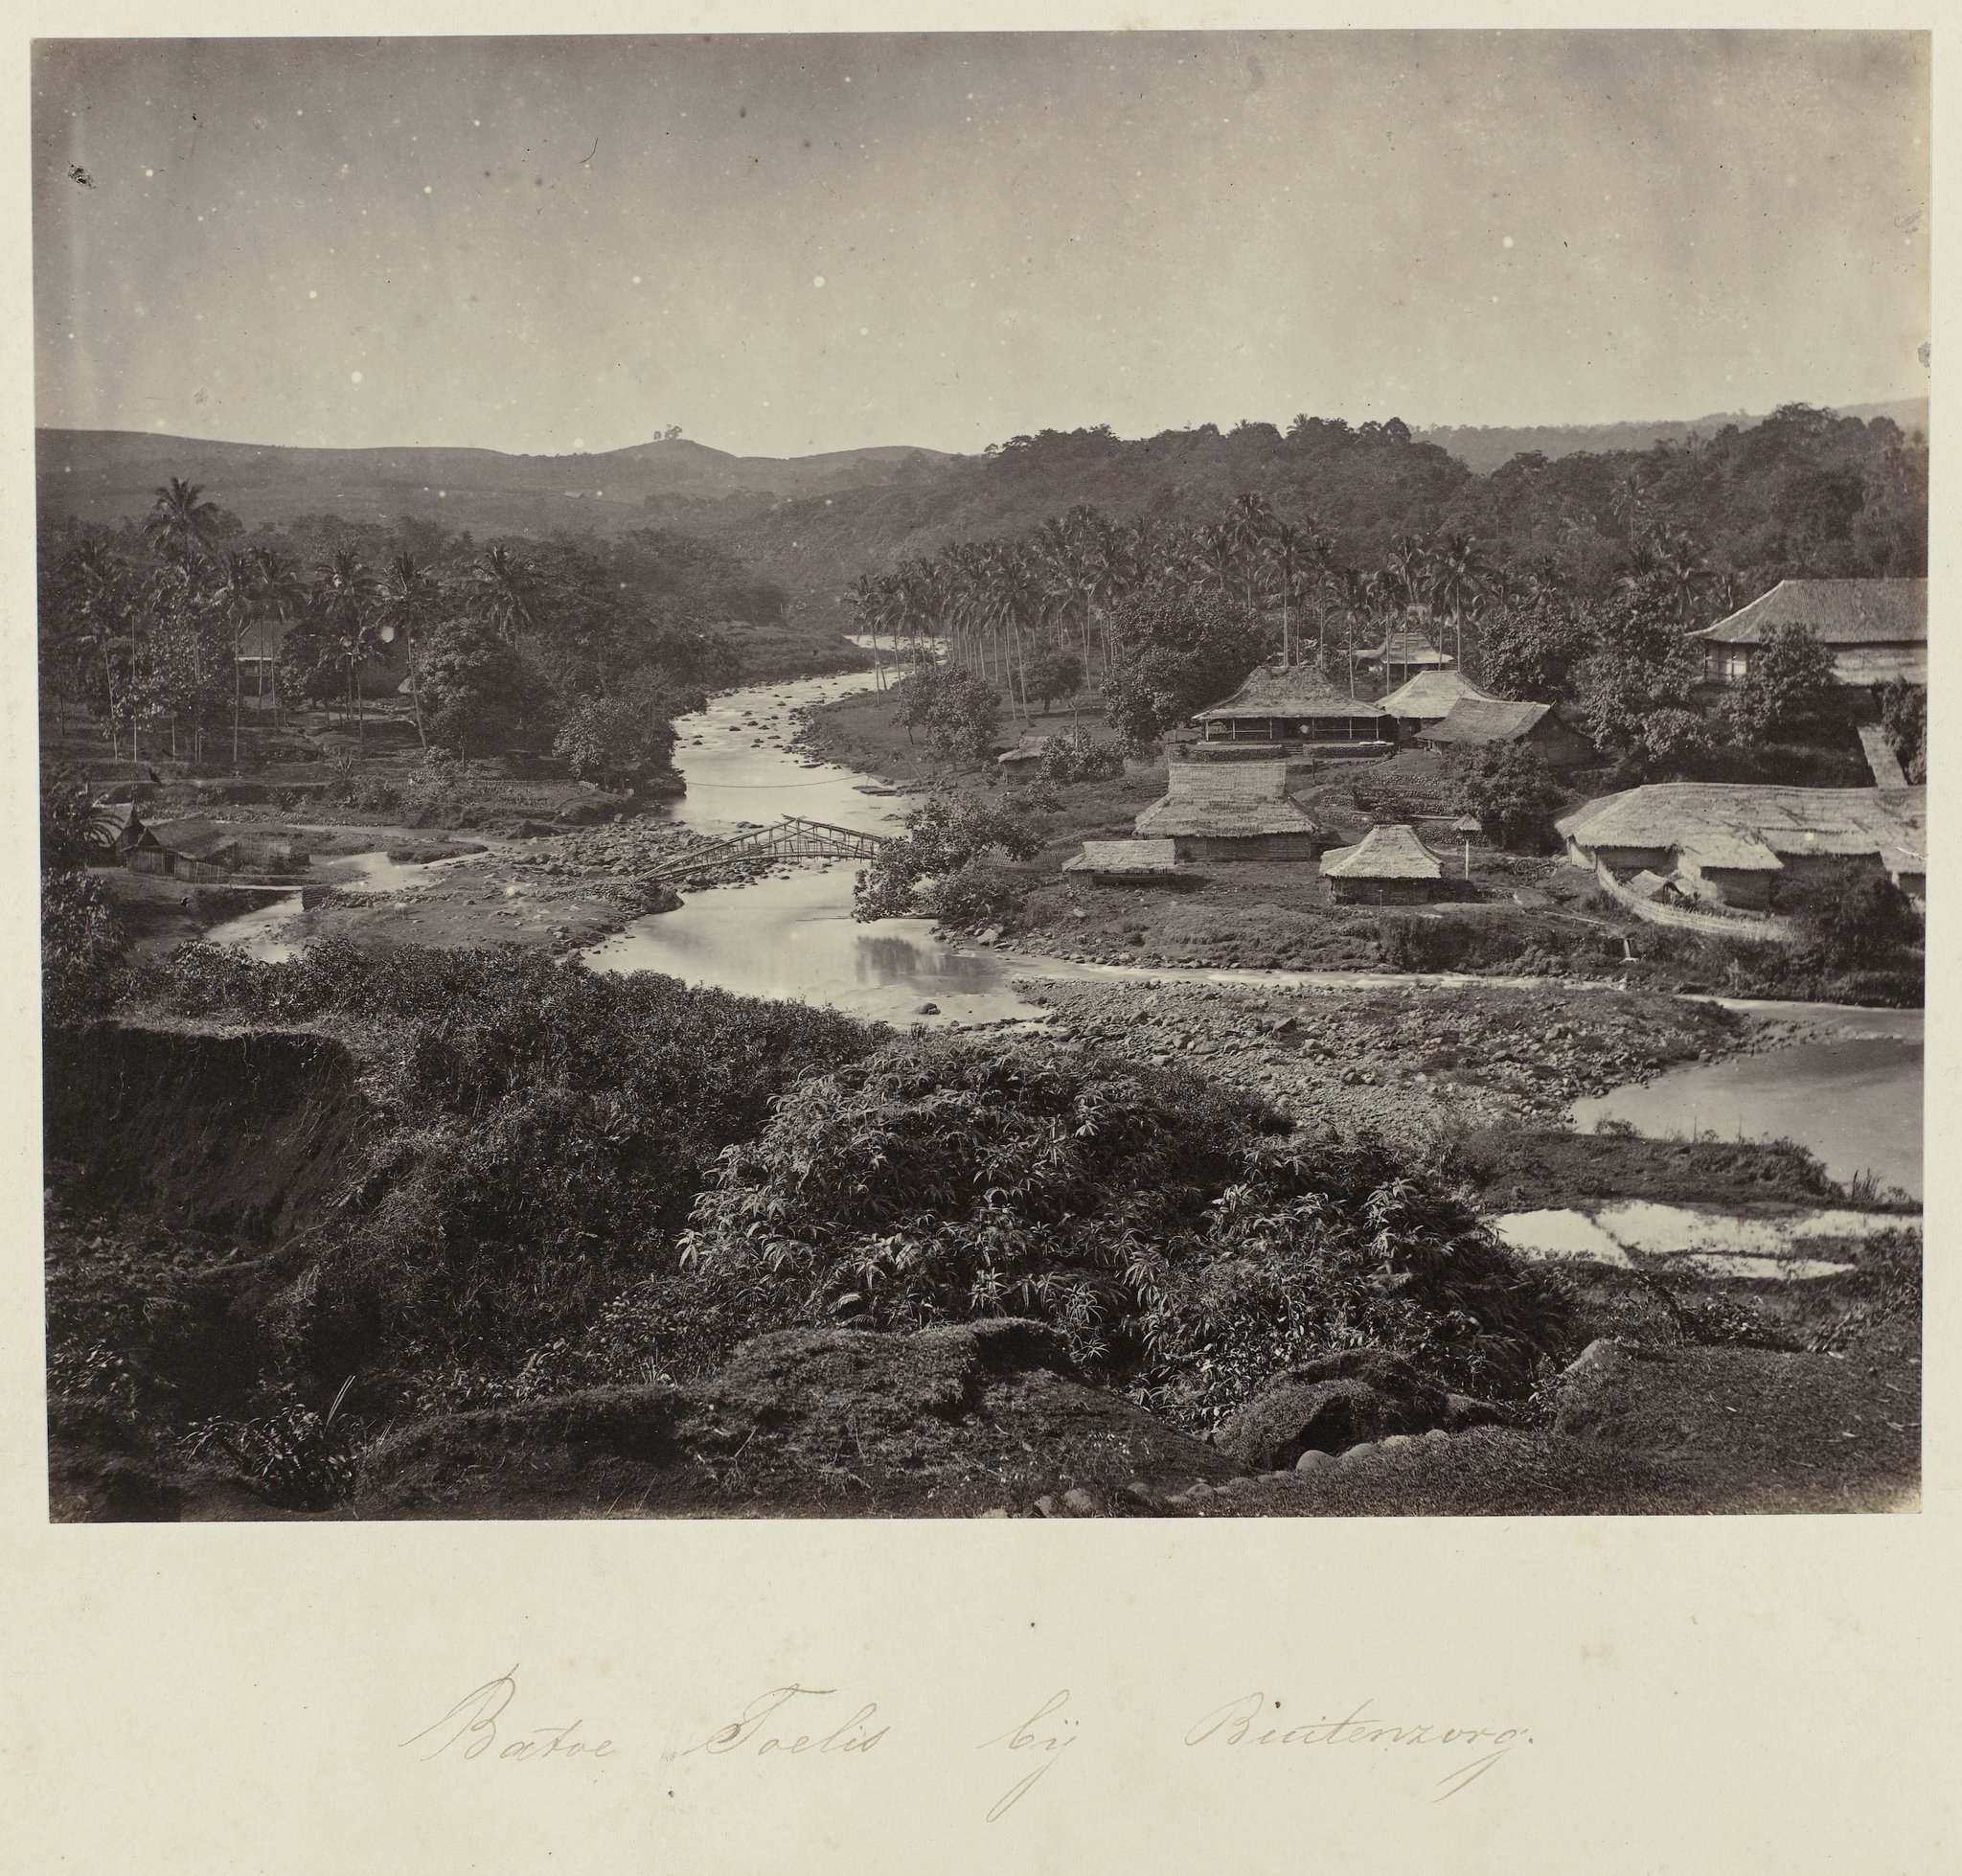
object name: photograph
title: Batoe Toelis bij Buitenzorg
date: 1863-1869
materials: photographic support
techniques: albumen print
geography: buitenzorg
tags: village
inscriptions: inscription: ‘Batoe Toelis bij Buitenzorg’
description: Gezicht op Batoe Toelis, een dorpje aan een rivier, bij Buitenzorg. Onderdeel van het groene fotoalbum met foto's van Java, uit het bezit van apotheker Specht-Grijp, die in 1865 vanuit Batavia naar Nederland terugkeerde.